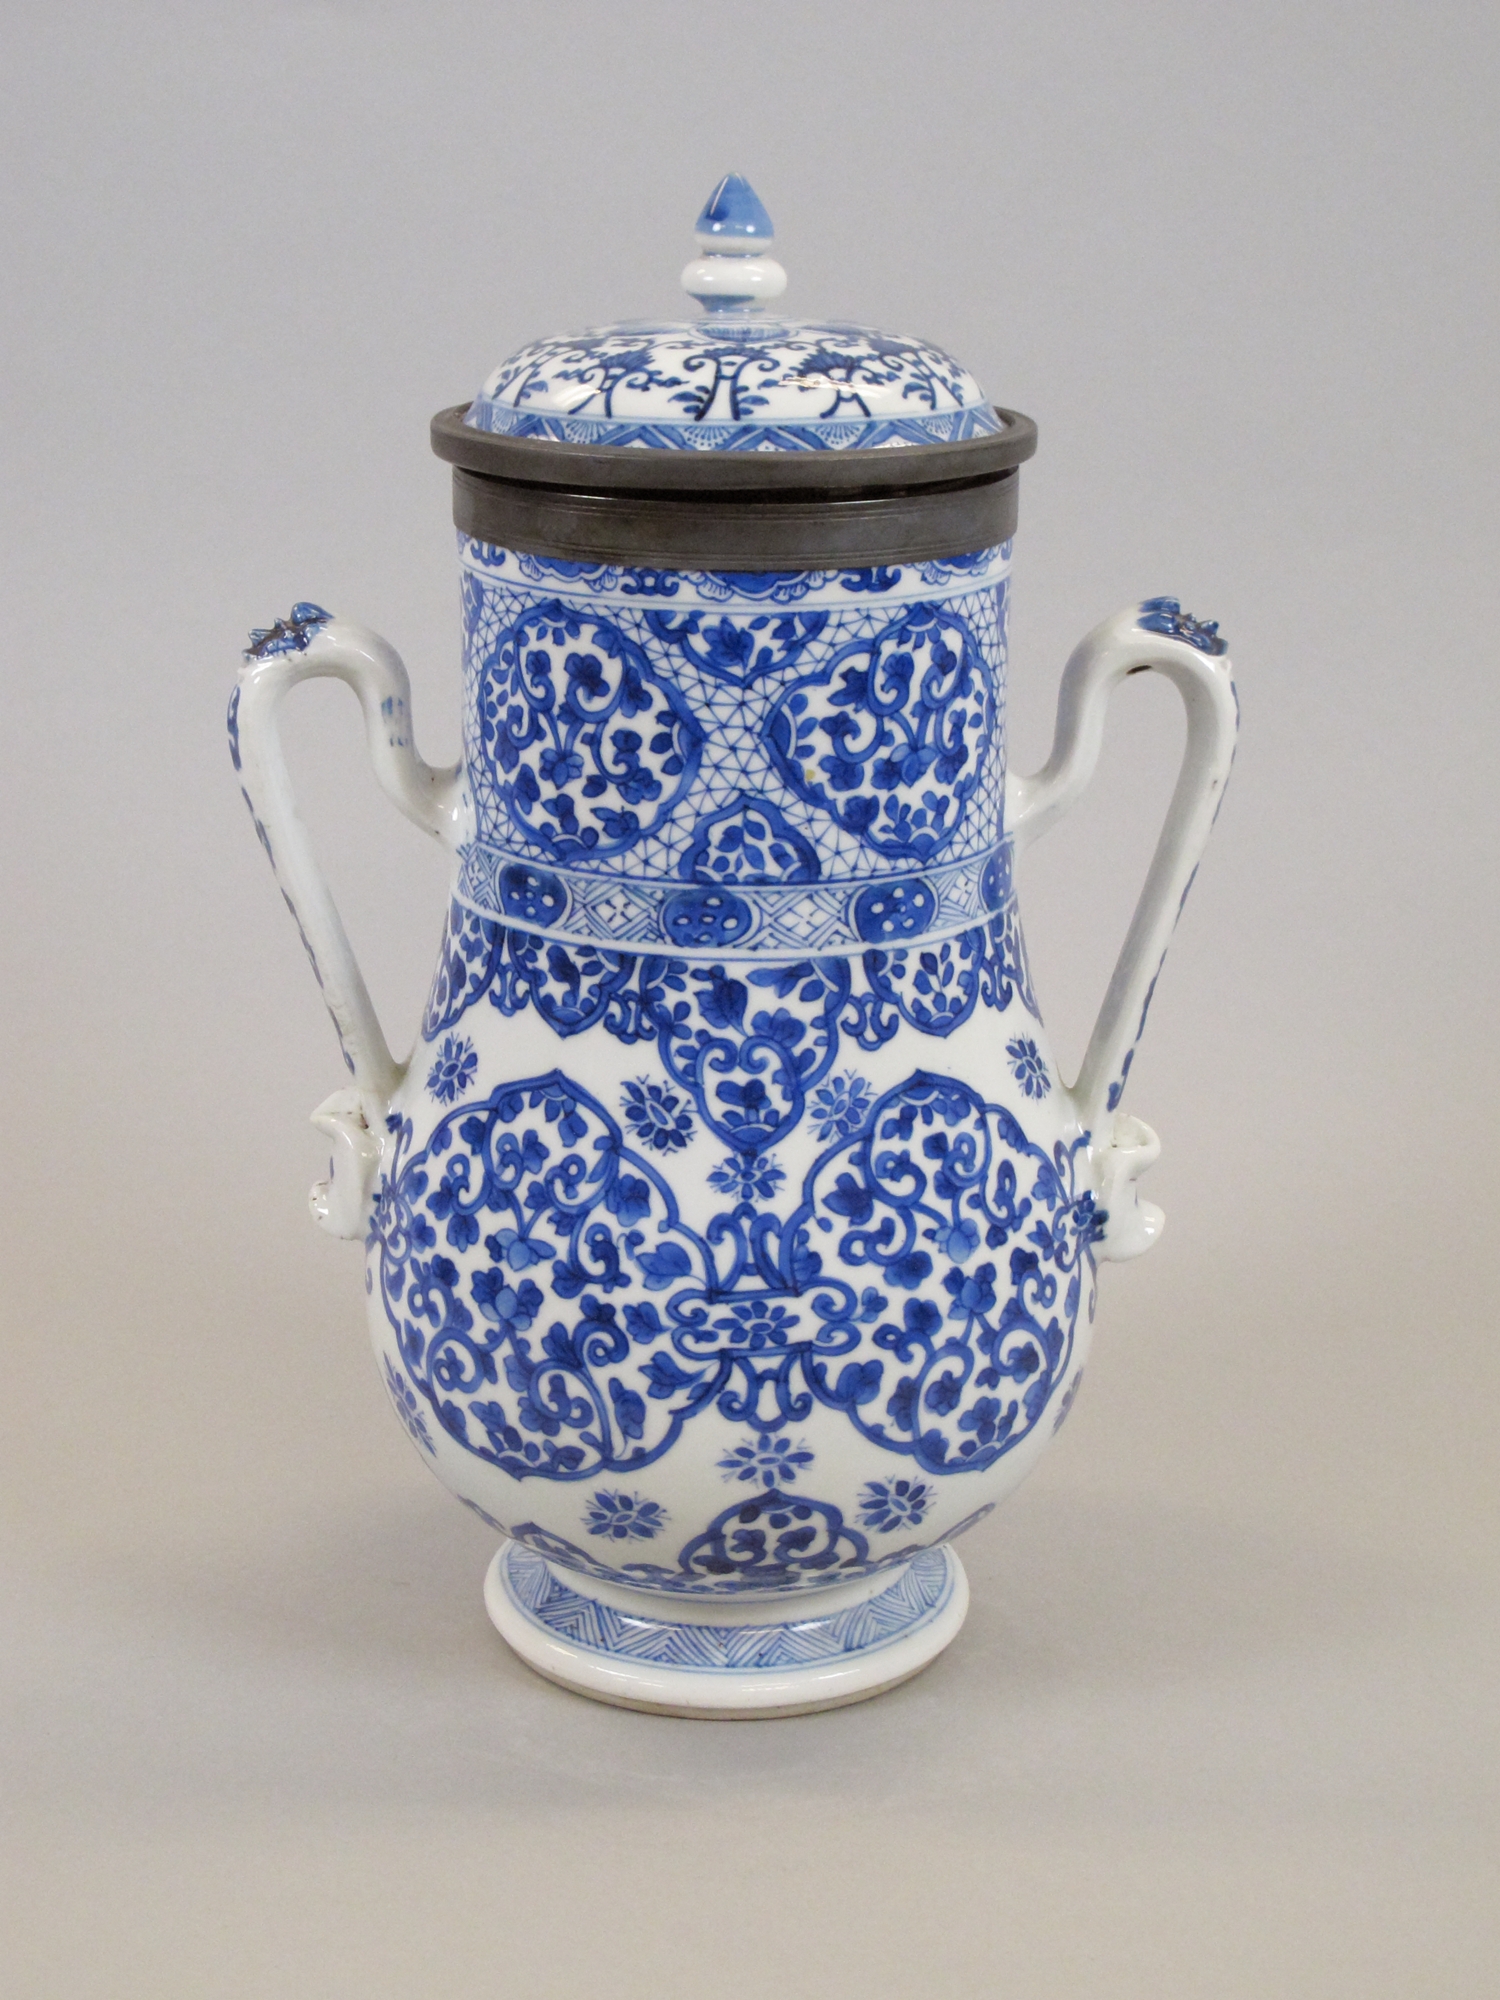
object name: covered jar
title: Covered jar with handles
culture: chinese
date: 1667-1733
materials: cobalt, porcelain, silver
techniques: painting, underglaze